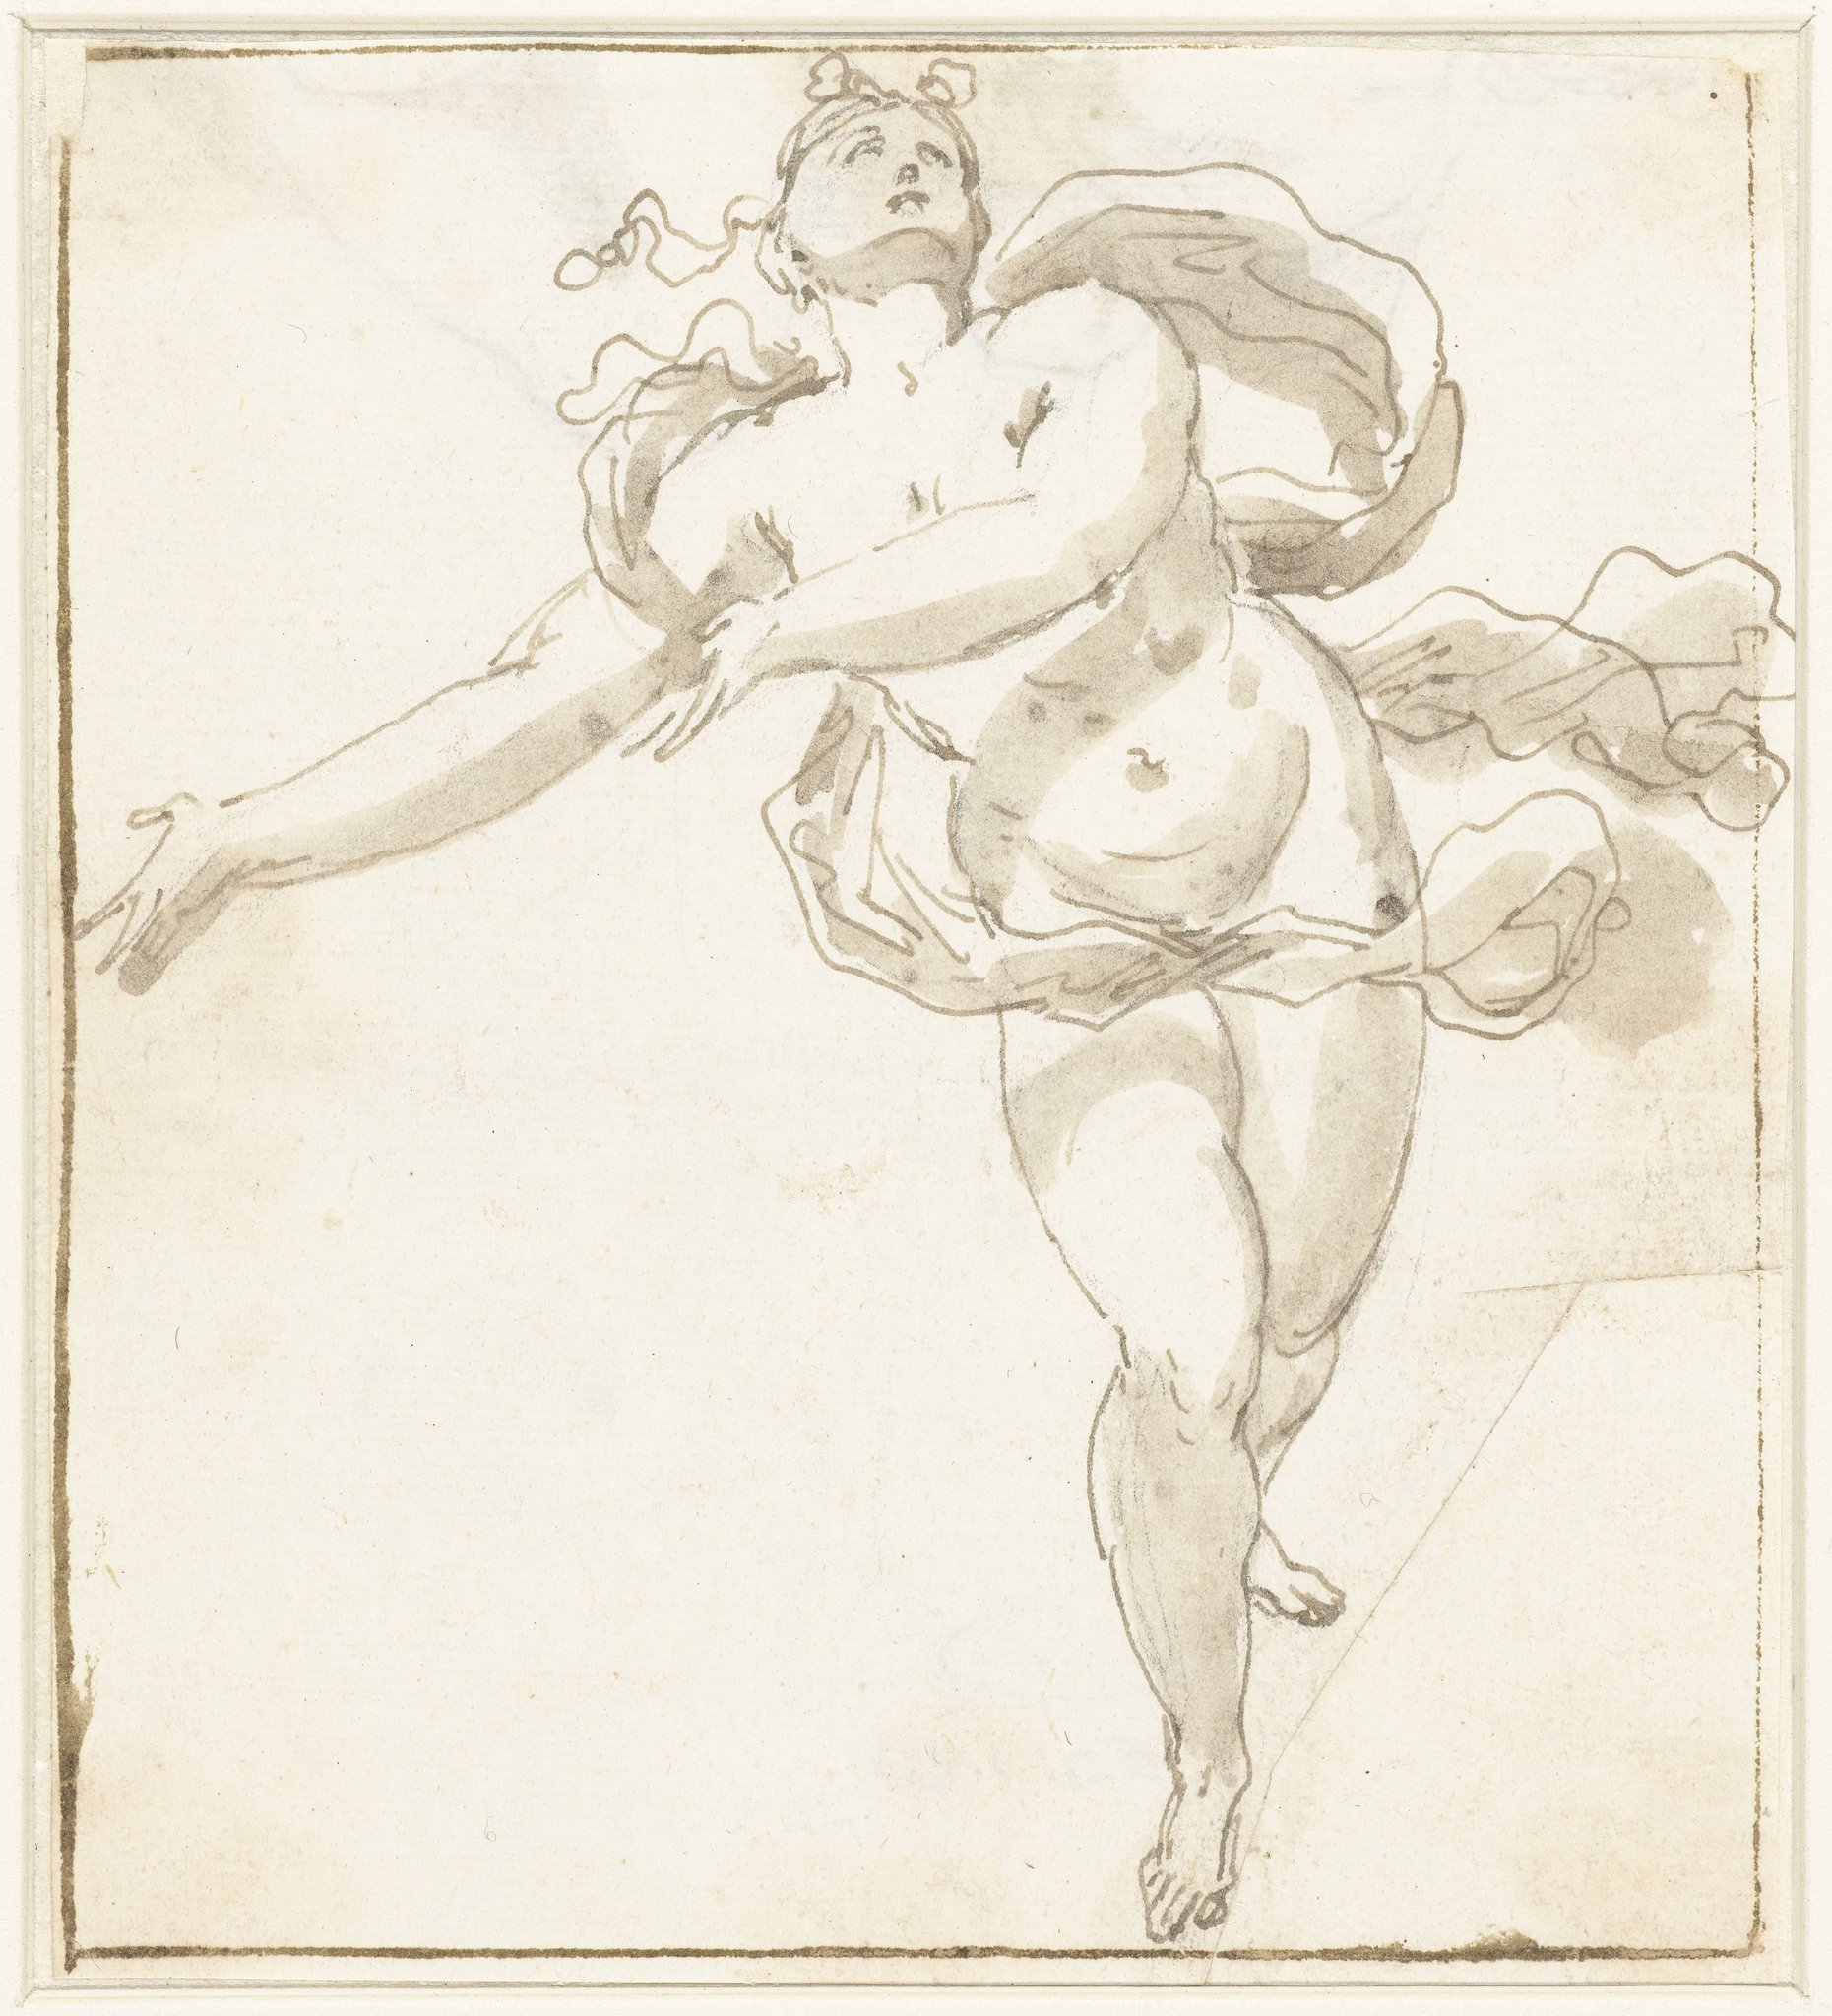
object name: drawing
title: Allegorische vrouwenfiguur (Fortuna?) met wapperende sjerp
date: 1620-1661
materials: chalk, ink, paper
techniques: brush, pen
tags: luck, fortune, lot; 'fato', 'fortuna', 'fortuna aurea', 'fortuna buona', 'fortuna pacifica overo clemente', 'sorte' (ripa)